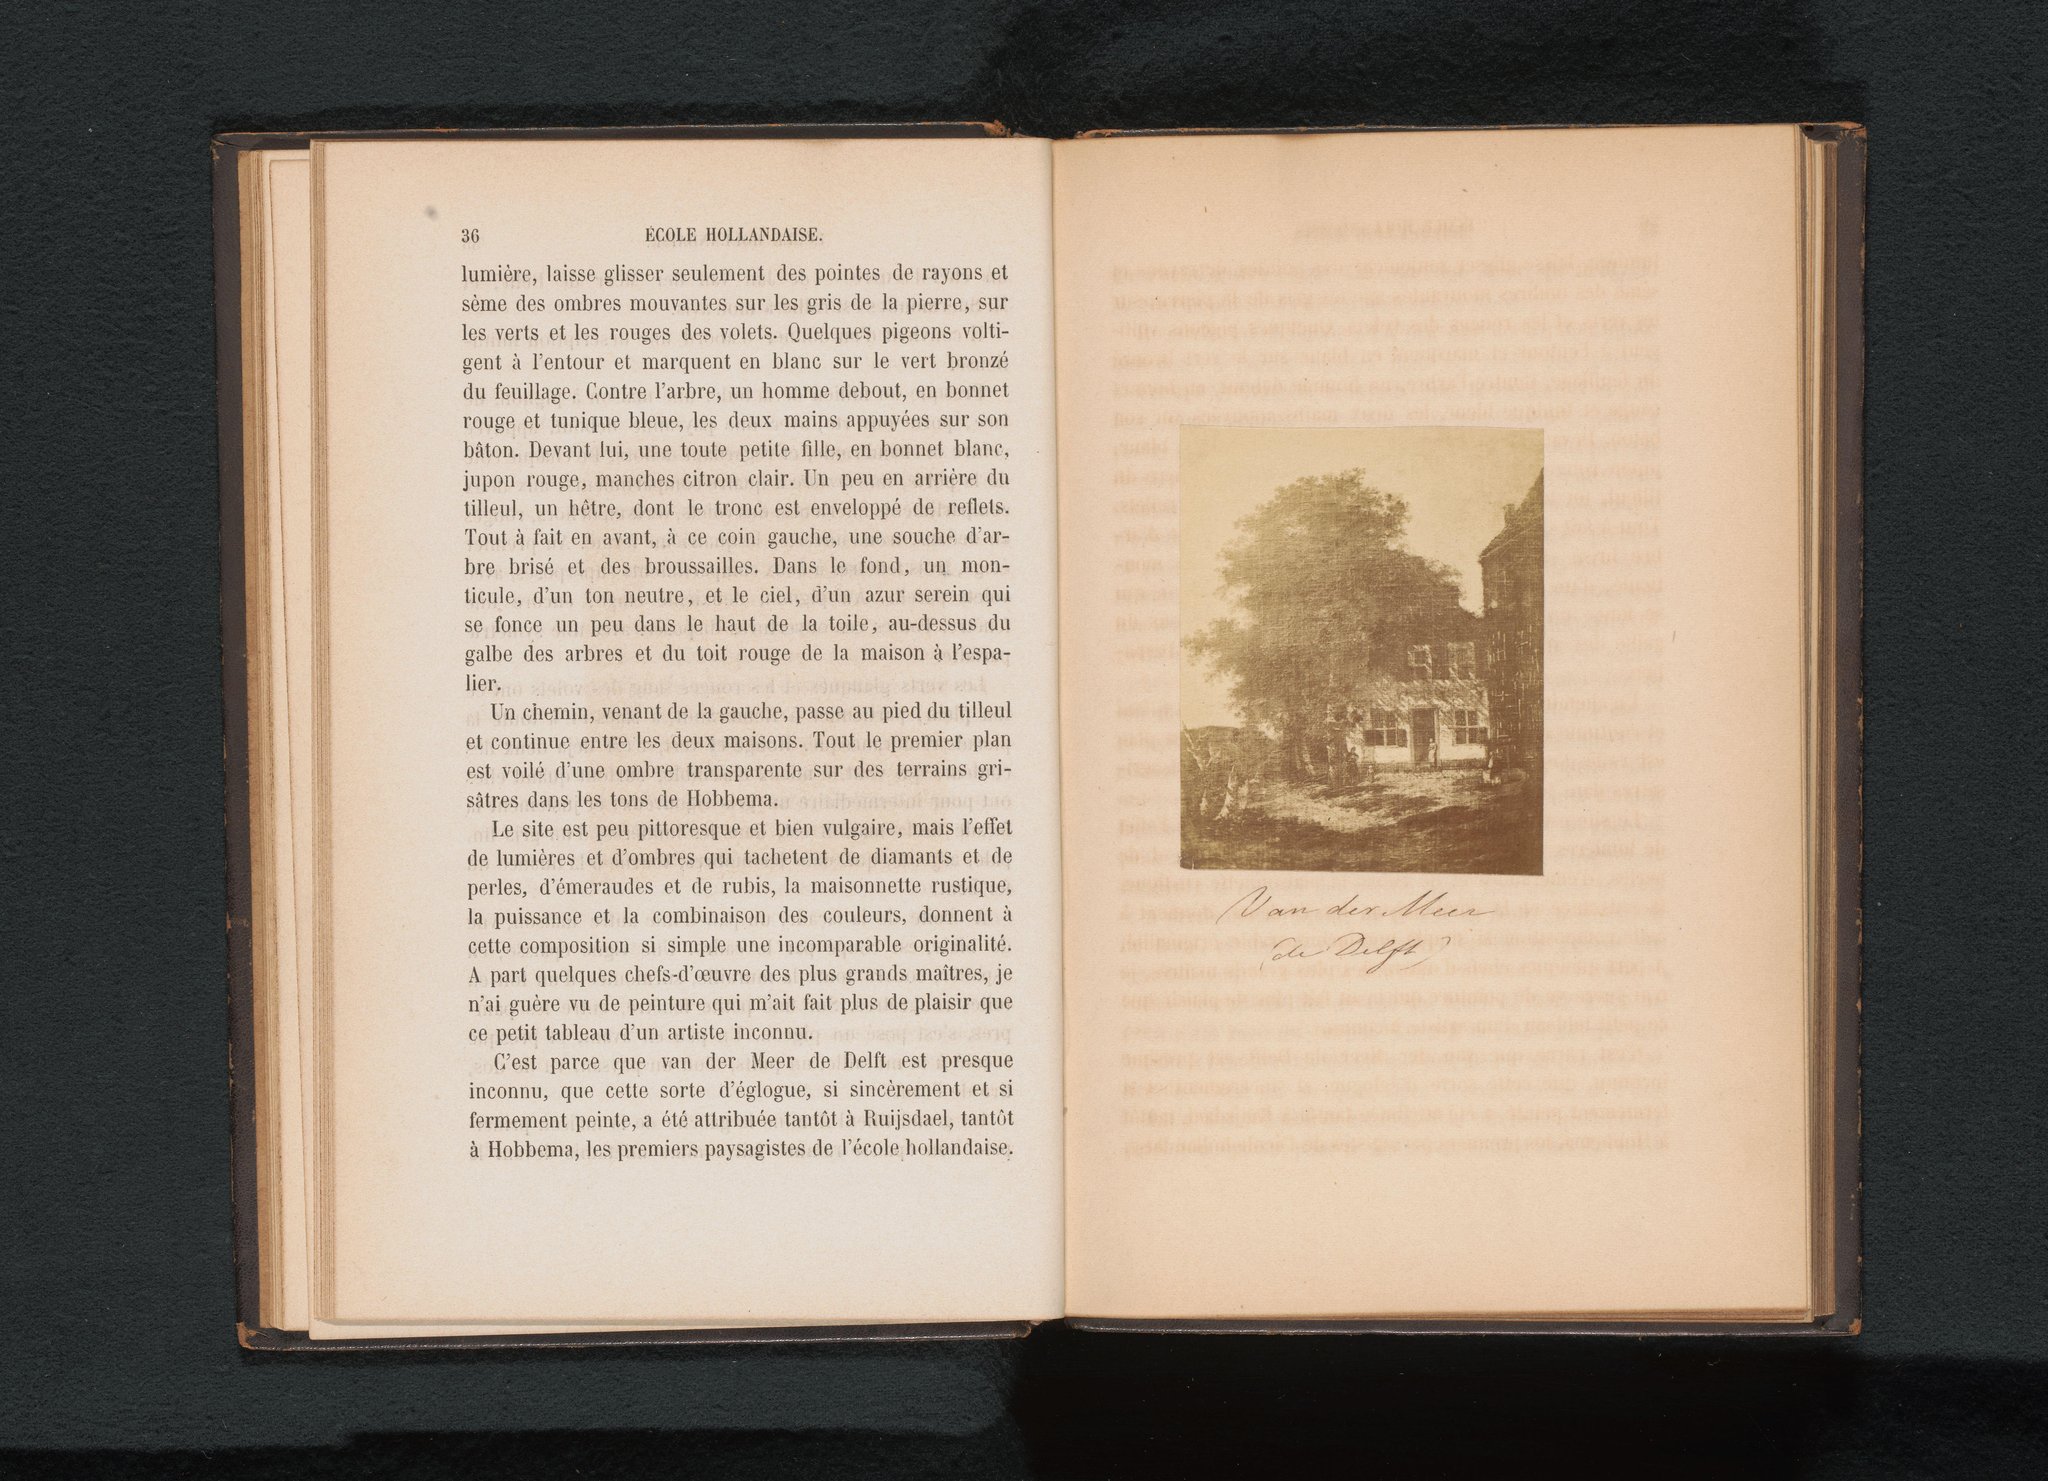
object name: page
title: Fotoreproductie van een schilderij van een huis en bomen door Jan van der Meer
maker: edmond fierlants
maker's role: fotograaf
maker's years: 1819-1869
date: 1855-1860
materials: photographic support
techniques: albumen print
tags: trees, civic architecture; edifices; dwellings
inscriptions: name: ‘Van der Meer/ (De Delft)’